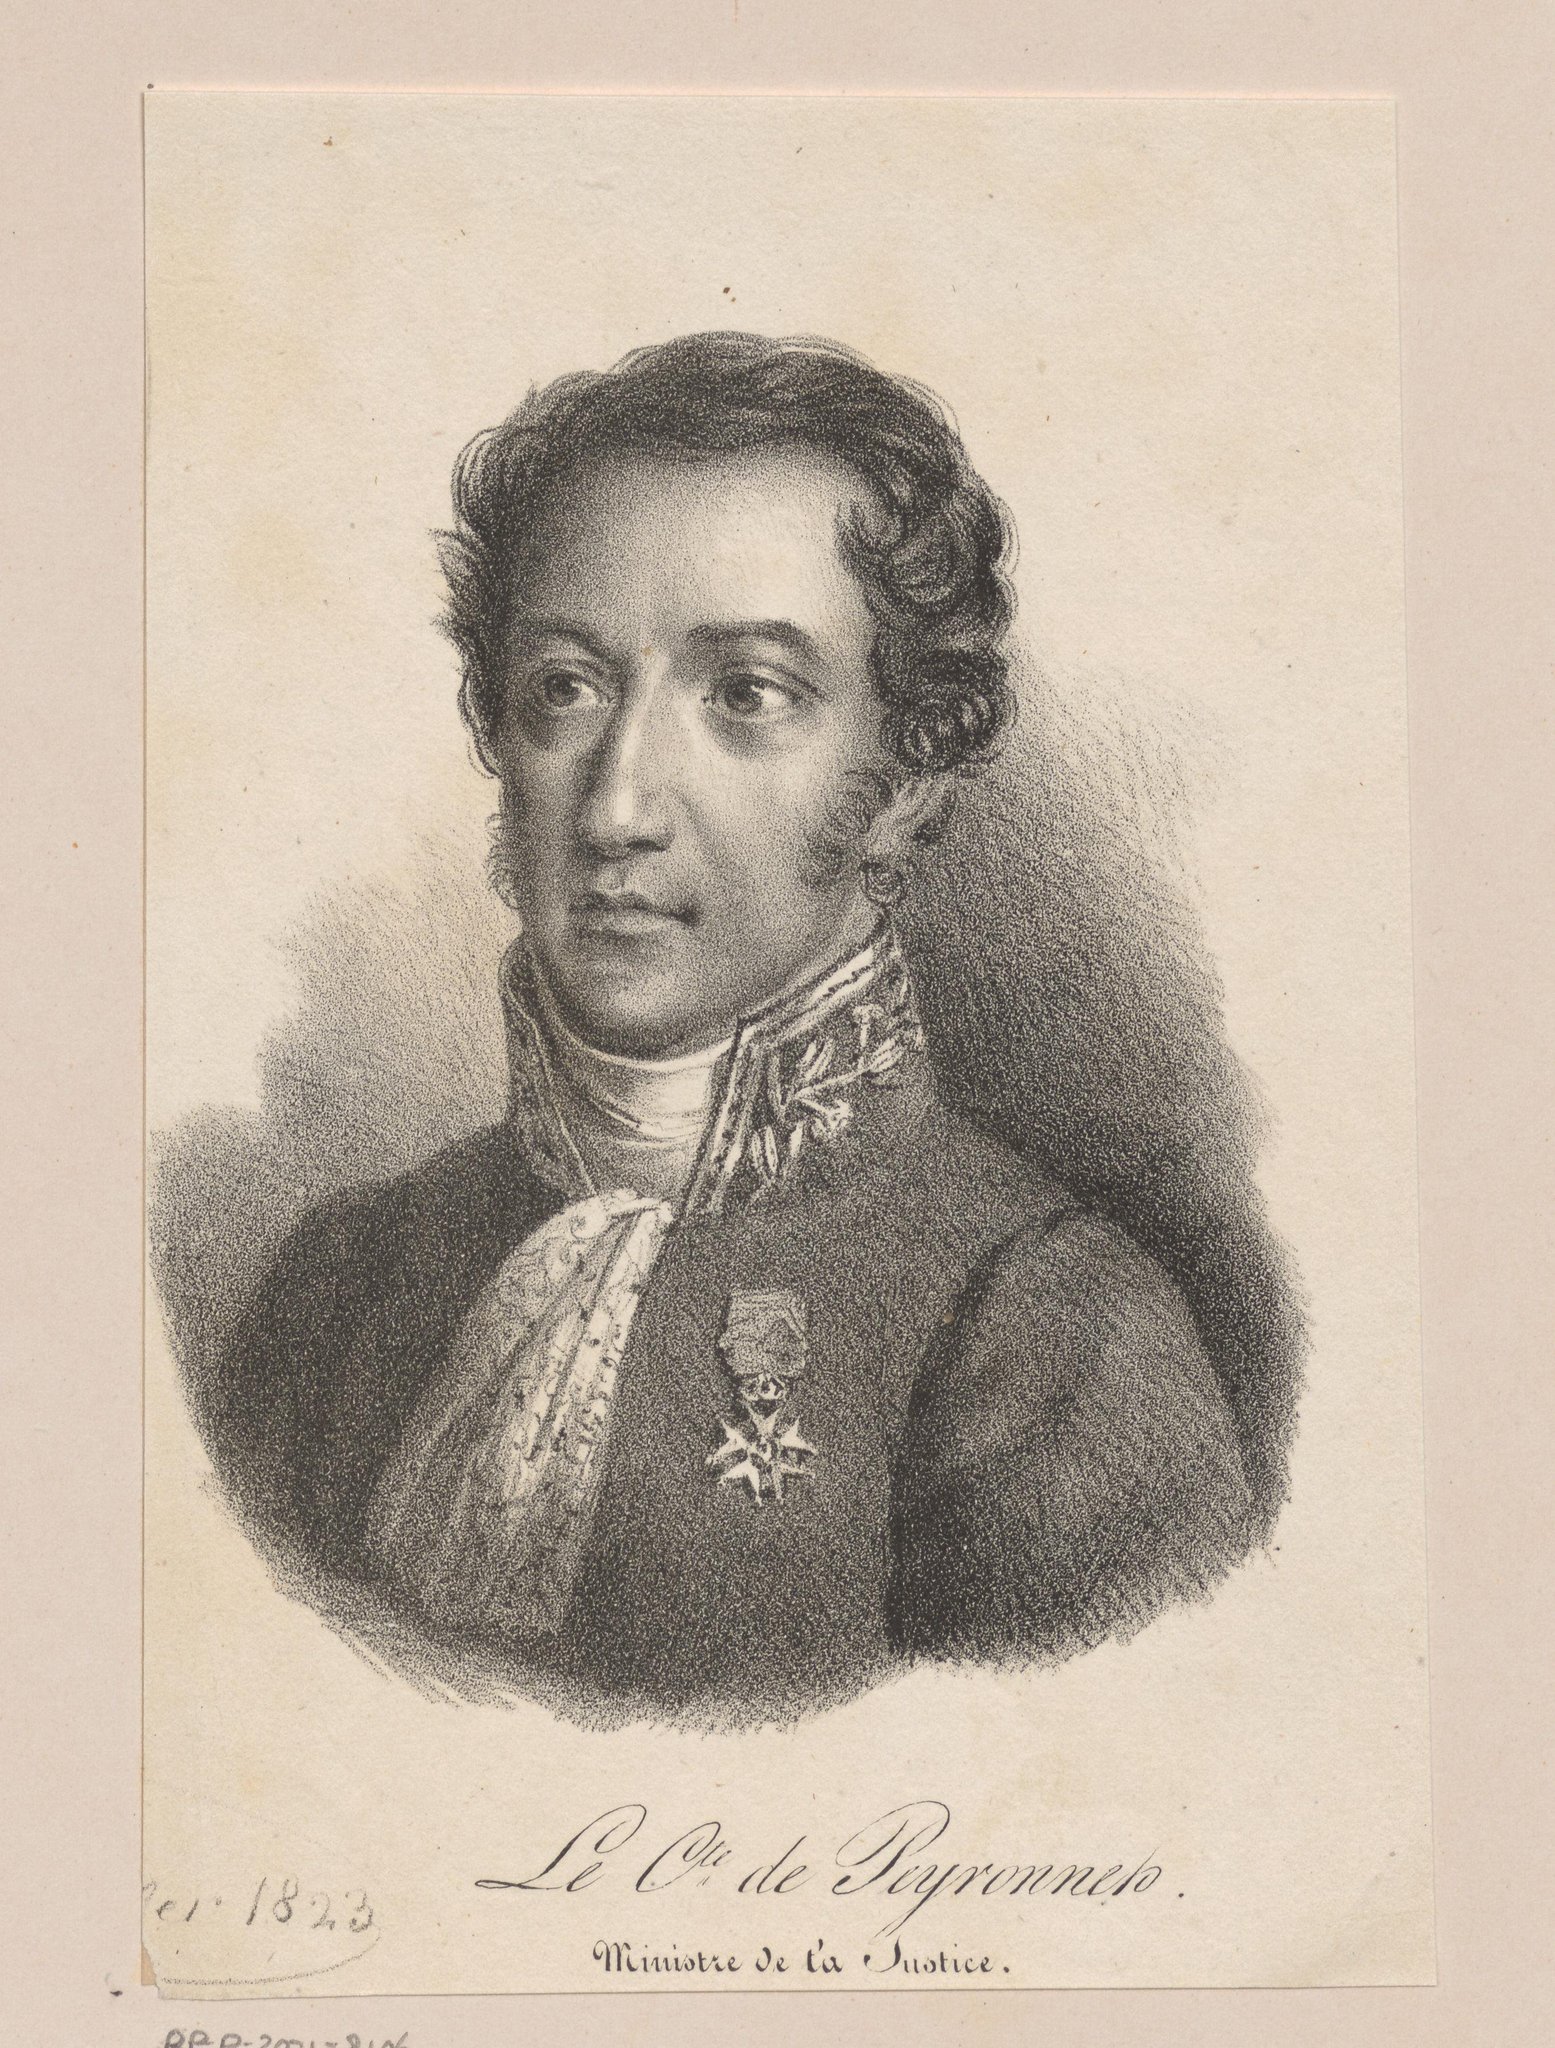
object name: print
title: Portret van Pierre-Denis de Peyronnet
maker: Anonymous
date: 1823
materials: paper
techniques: lithograph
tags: adult man, historical persons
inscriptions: mark: ‘[...]er 1823’